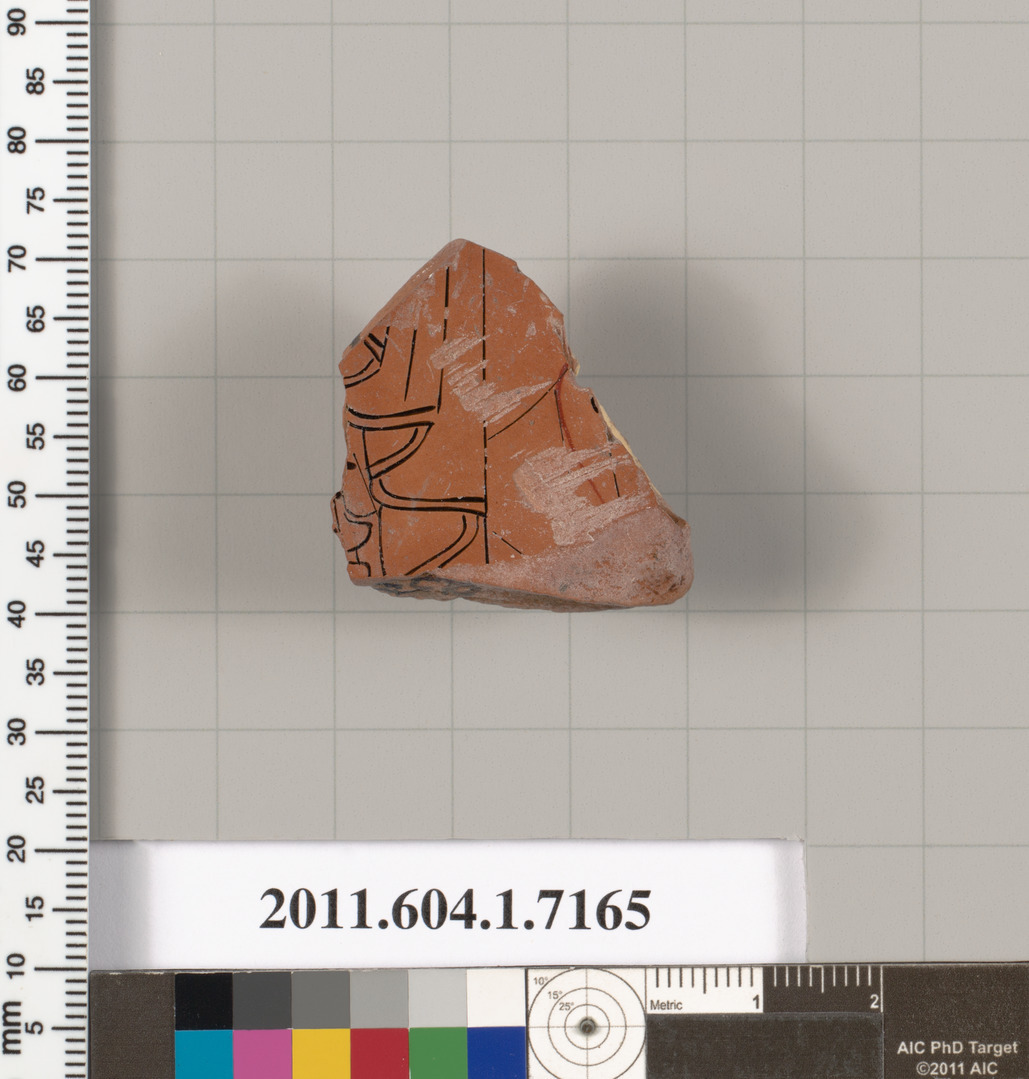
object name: kylix fragment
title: Terracotta fragment of a kylix (drinking cup)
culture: greek, attic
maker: makron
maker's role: artist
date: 500-480 BCE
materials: terracotta